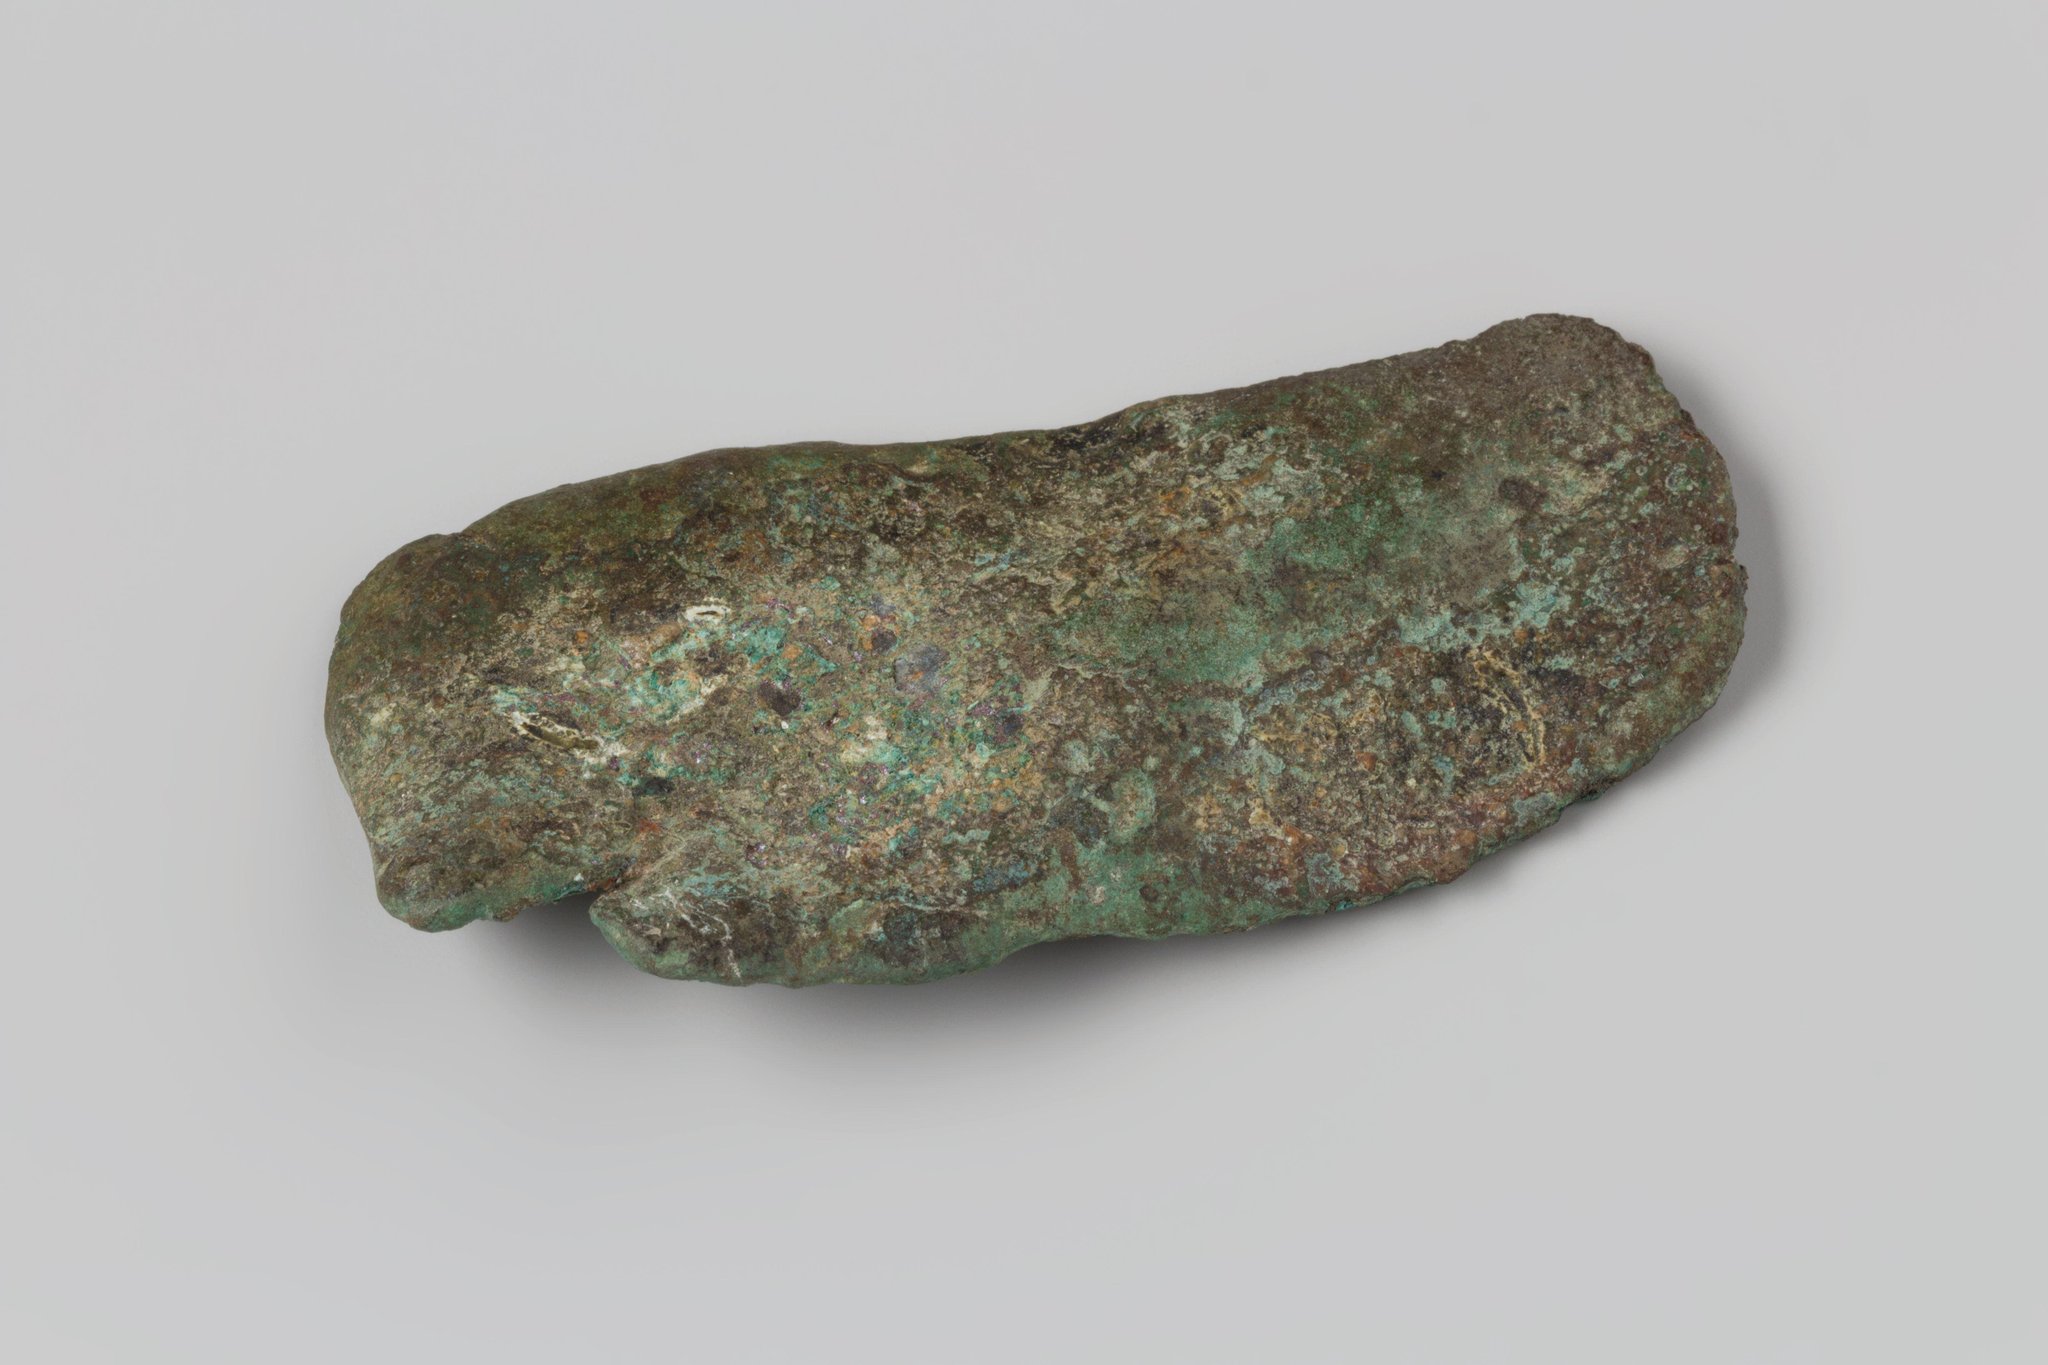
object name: scheepswrakvondst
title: Fragment van koper uit het wrak van de Oost-Indiëvaarder Hollandia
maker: Anonymous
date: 1700-1743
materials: copper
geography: netherlands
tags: verenigde oostindische compagnie, hollandia (schip), annet